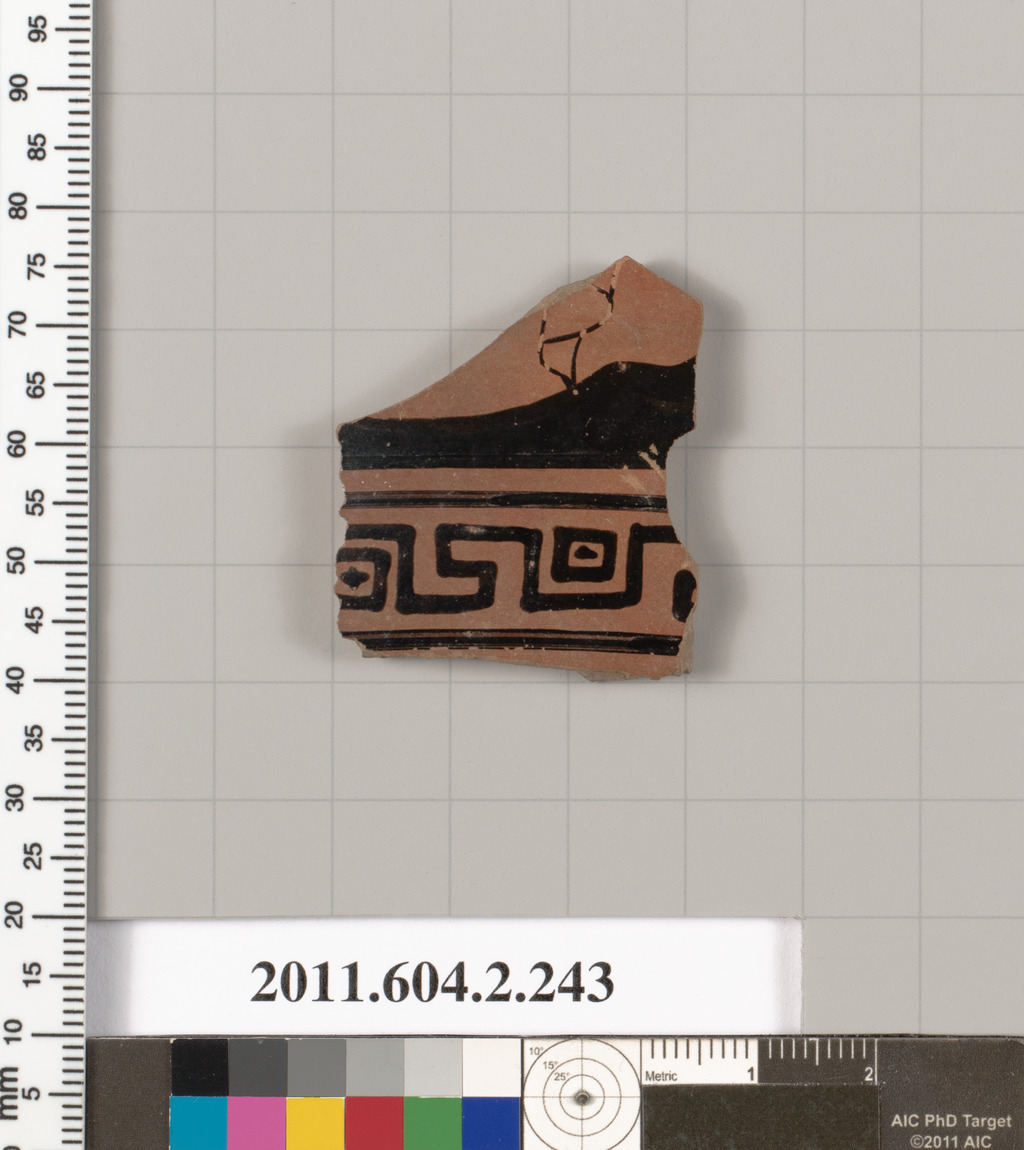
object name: stamnos fragment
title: Terracotta fragment of a stamnos (jar)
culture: greek, attic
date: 480-470 BCE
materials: terracotta